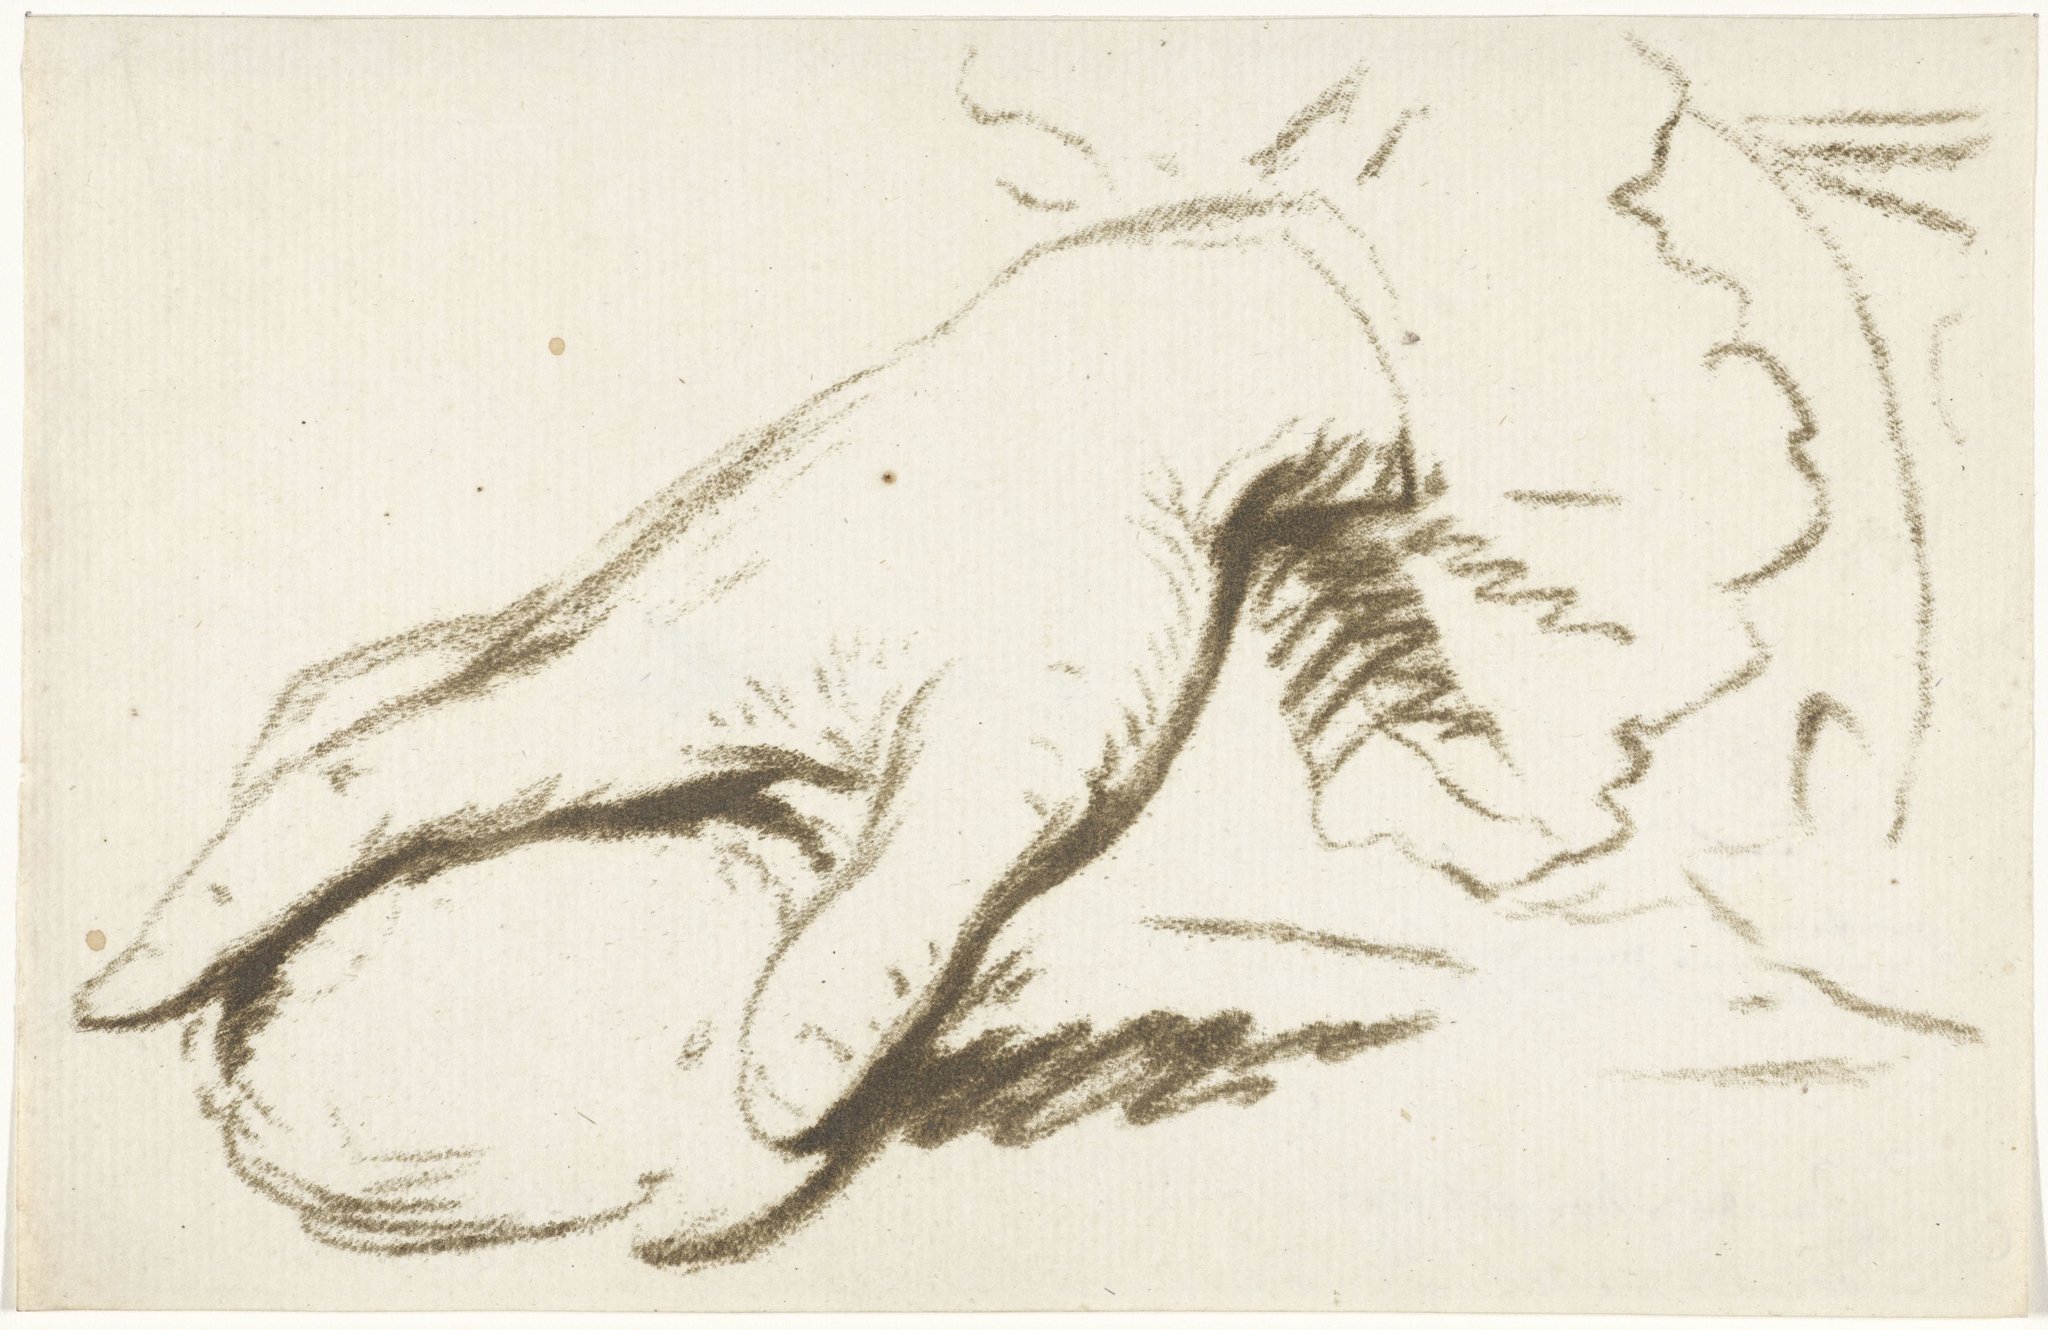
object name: print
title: Hand met rond voorwerp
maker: cornelis ploos van amstel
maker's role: draughtsman, print maker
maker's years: 1726-1798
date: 1758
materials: paper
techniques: printing, printmaking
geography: amsterdam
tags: hand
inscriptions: collector's mark: Lugt 240, inscription: ‘geoffreerd aan mijne waarde neef den Heere J: L v Dussen // G Van der Myn del 1757 Ploos v Amstel JC: F 1758’